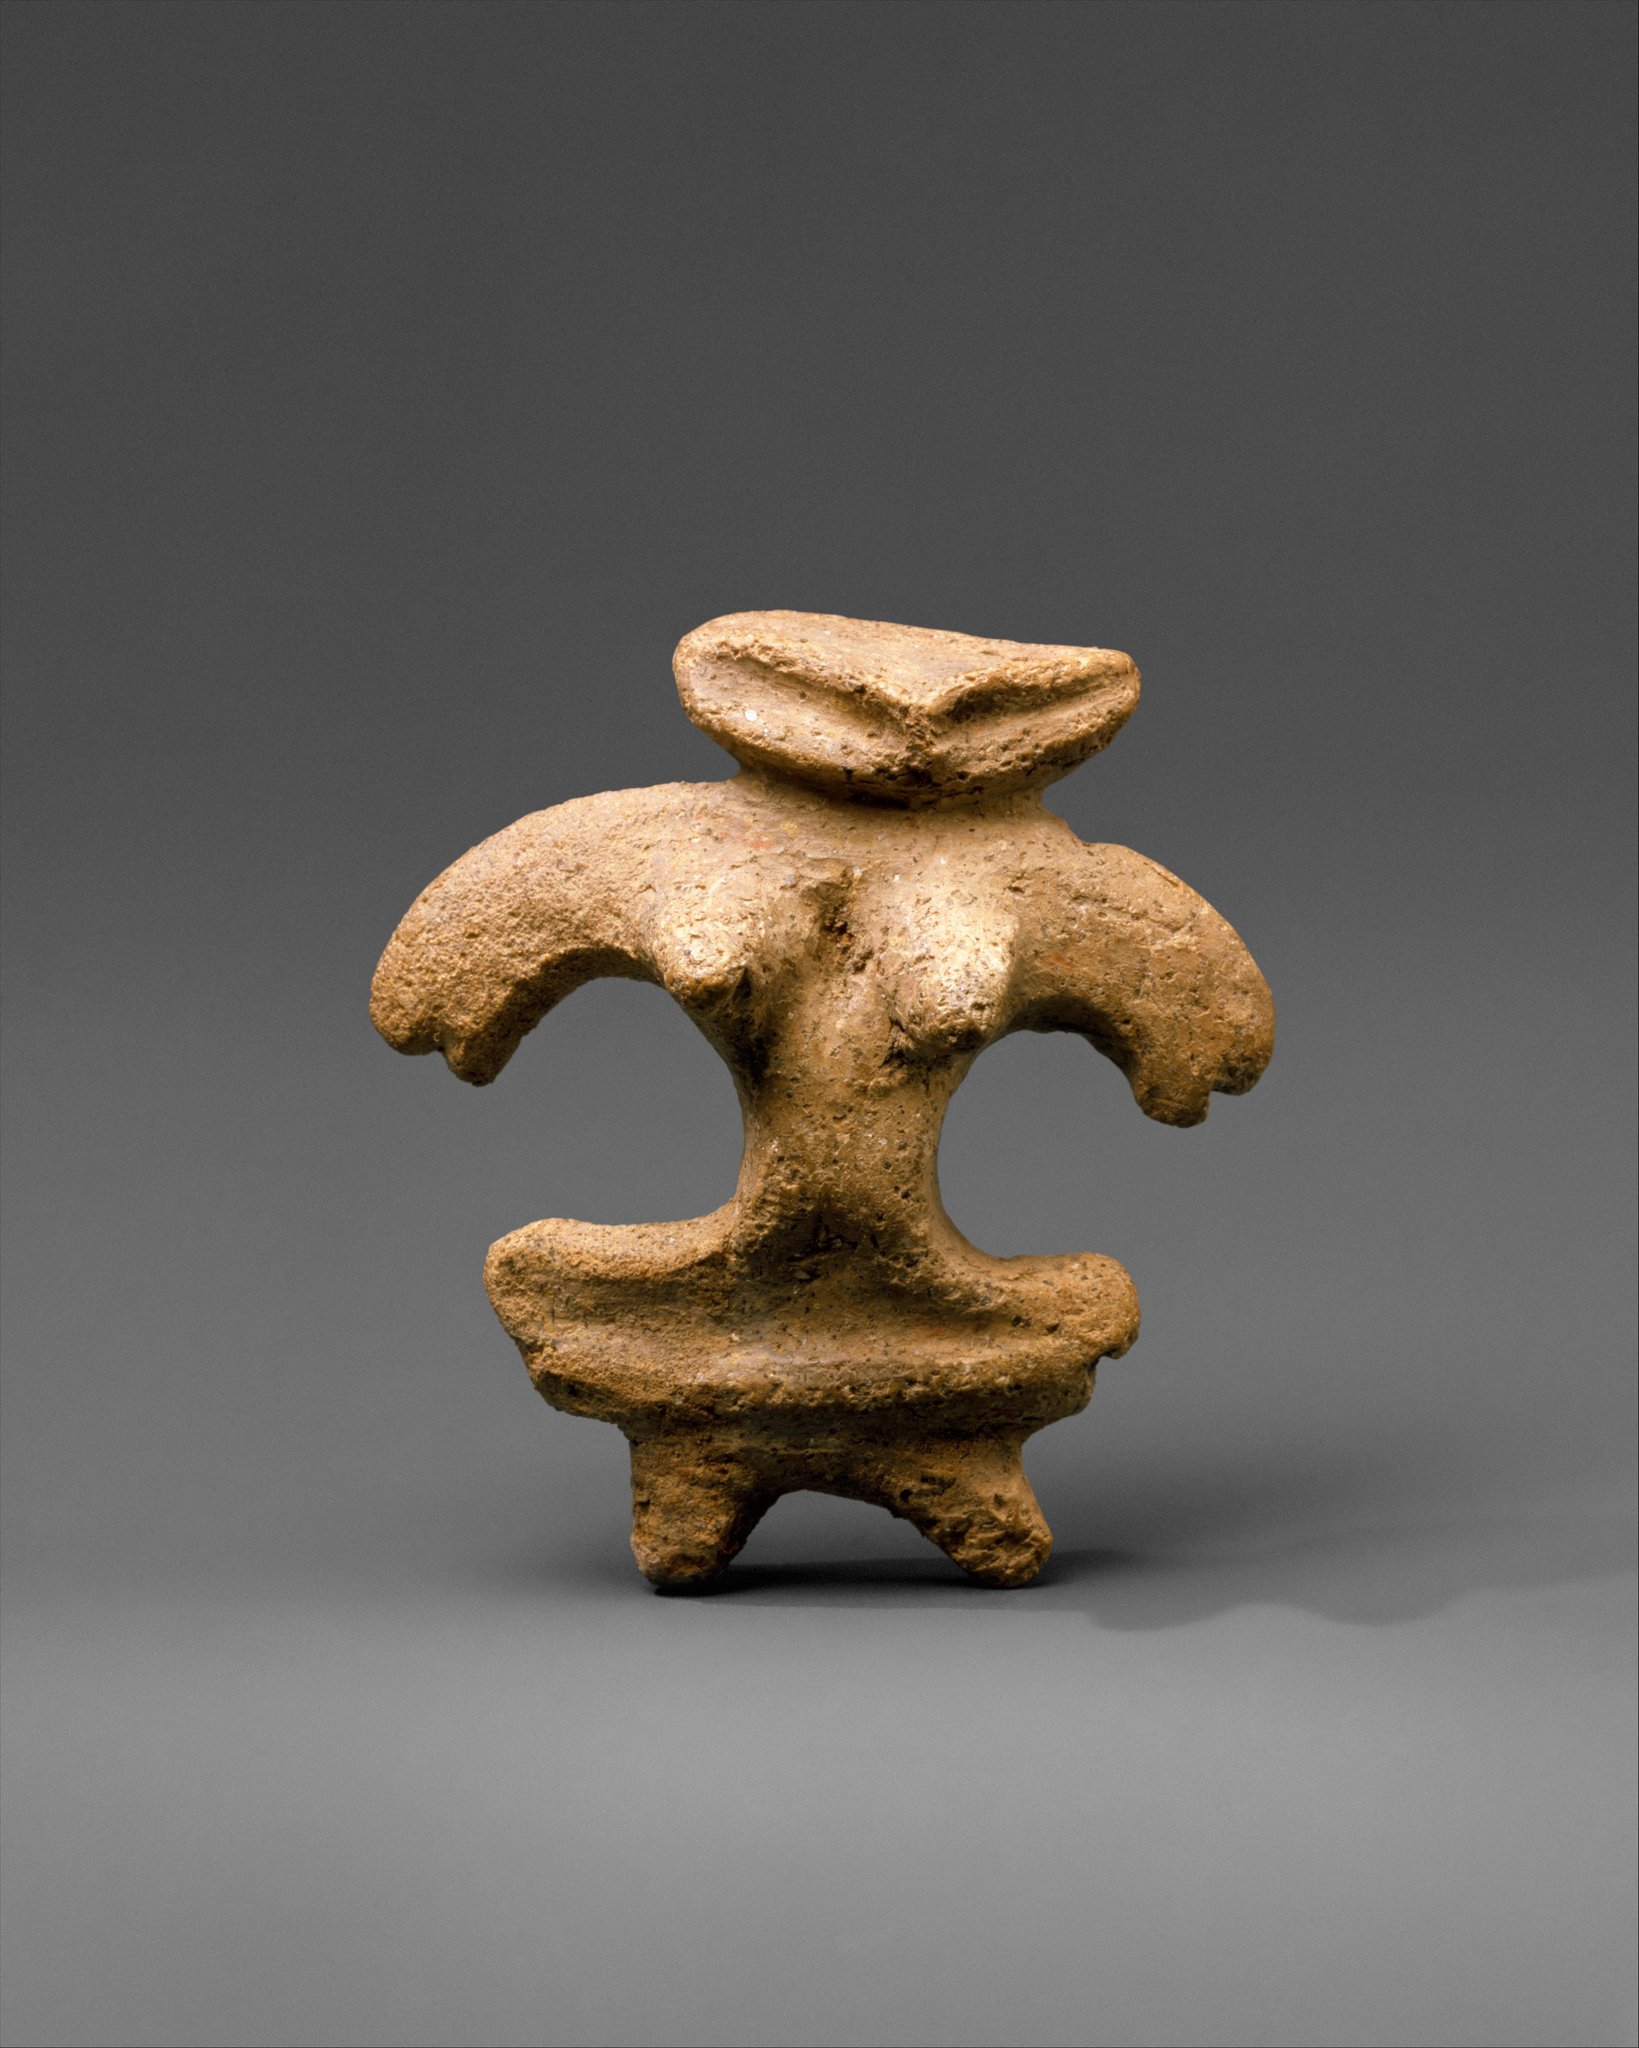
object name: figurine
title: Dogū (Clay Figurine)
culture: japanese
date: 1050-200 BCE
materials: earthenware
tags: female nudes